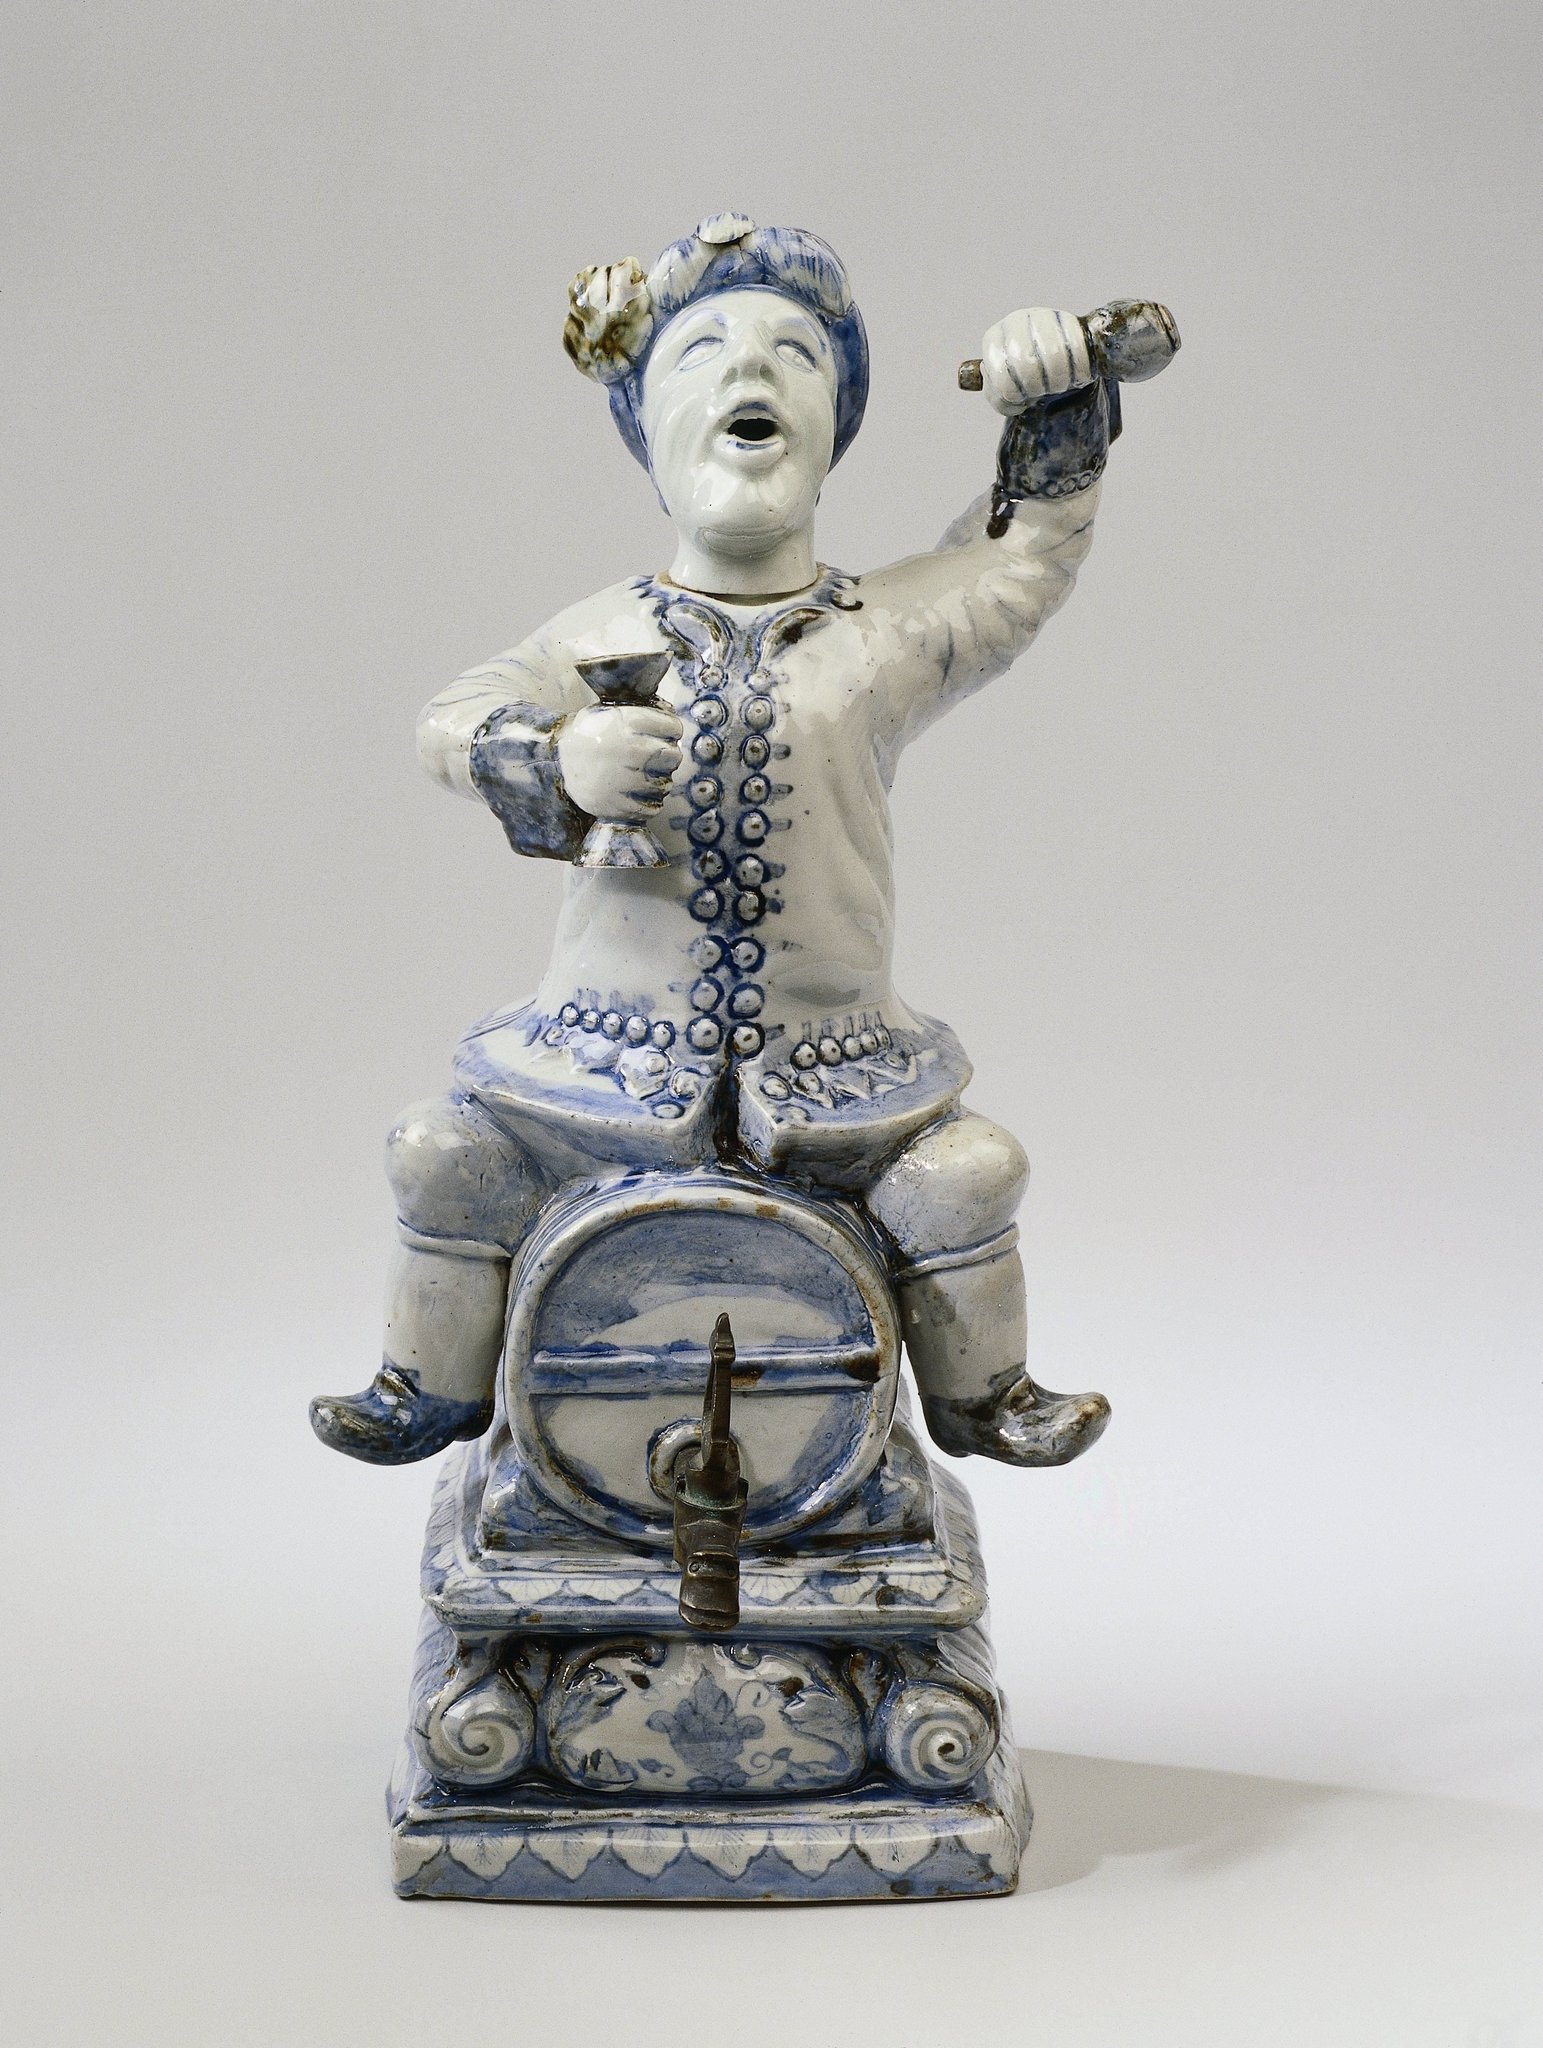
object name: figure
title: Spirit keg in the shape of a Dutchman sitting astride a barrel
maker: Anonymous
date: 1750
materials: brass, cobalt, glaze, paint, porcelain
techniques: firing, forming, vitrification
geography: japan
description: Humorous drinking vessels in the shape of a guzzling figure seated on a barrel were popular in Europe in the early 18th century. They were made of Delft earthenware, as well as Japanese porcelain. The head is detachable and a European copper tap has been added.